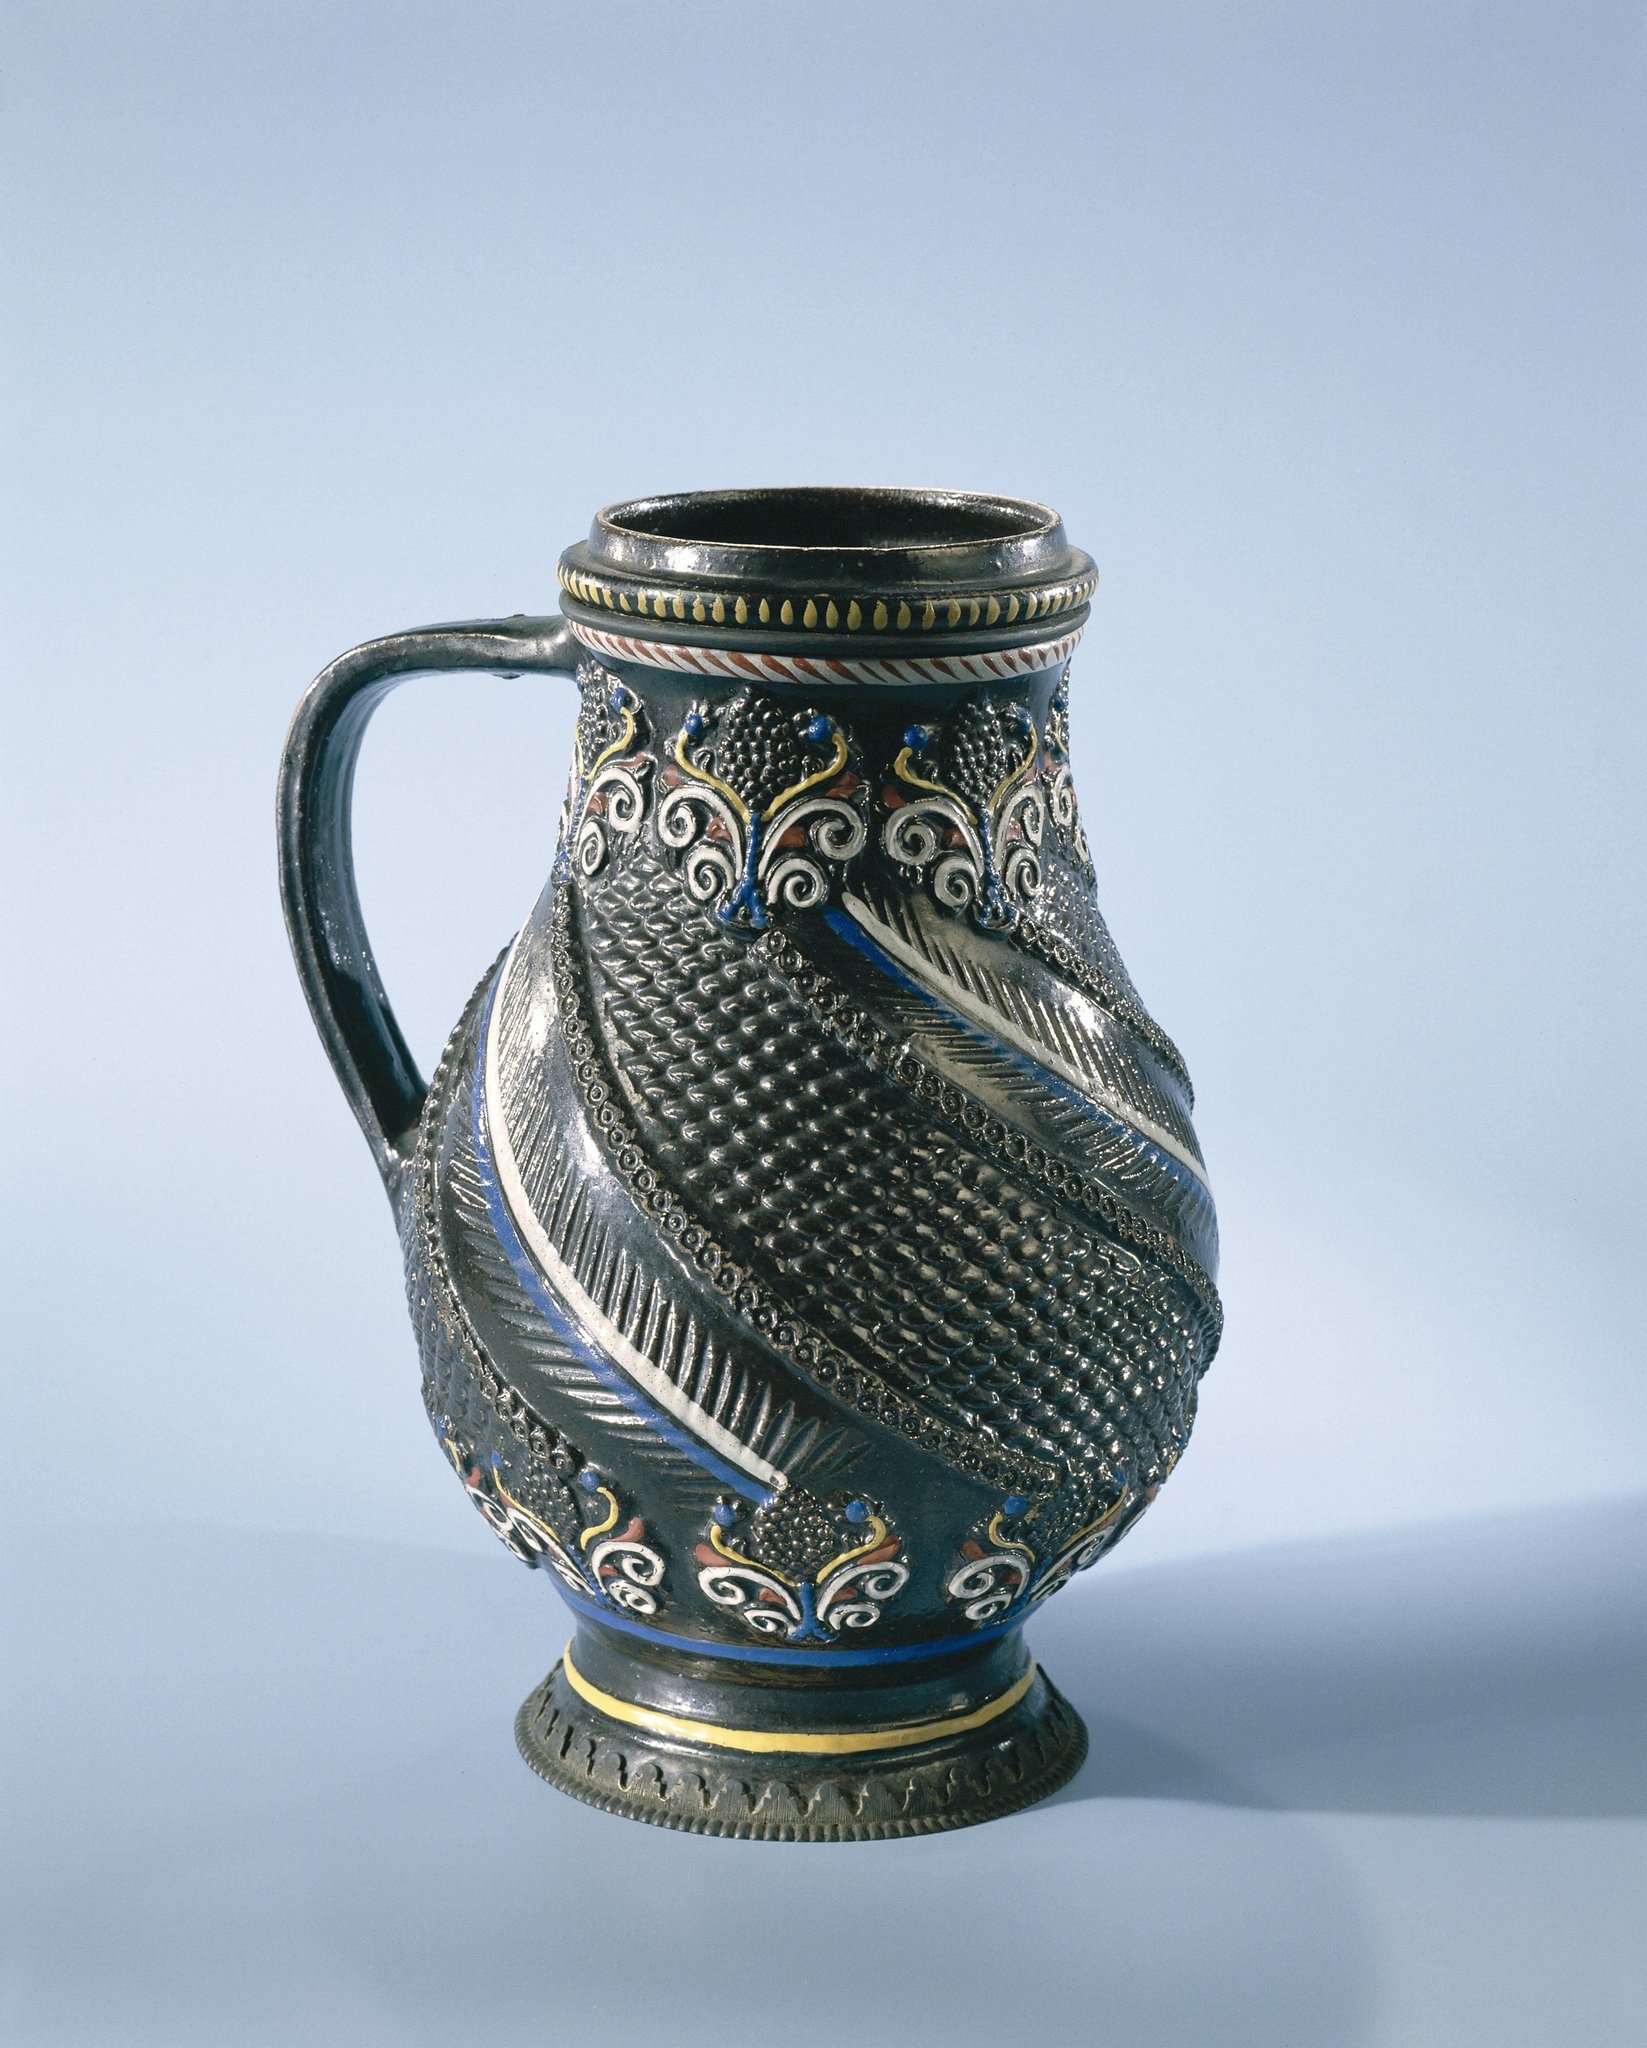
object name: jug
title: Jug with twisted borders with scale and fishbone motif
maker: Anonymous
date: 1670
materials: engobe, glaze, silver, stoneware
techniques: firing, forming, relief, turning, vitrification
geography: dippoldiswalde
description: Kruik van steengoed op hoge voet met een peervormig lichaam en wijde nek. Het C-vormige oor is bevestigd aan de nek en de buik. Profielen op de nek en voet. Bedekt met een bruine engobe en beschilderd met emailkleuren in blauw, rood, geel en wit. Op de buik getordeerde banden met een schub- of graatmotief, gescheiden door een gedrukte en opgelegde band in reliëf met cirkels. Boven de voet en op de nek een band met granaatappelmotieven. De voet is gevat in een zilveren montuur; deksel ontbreekt. Annaberg/ Dippoldiswalde.